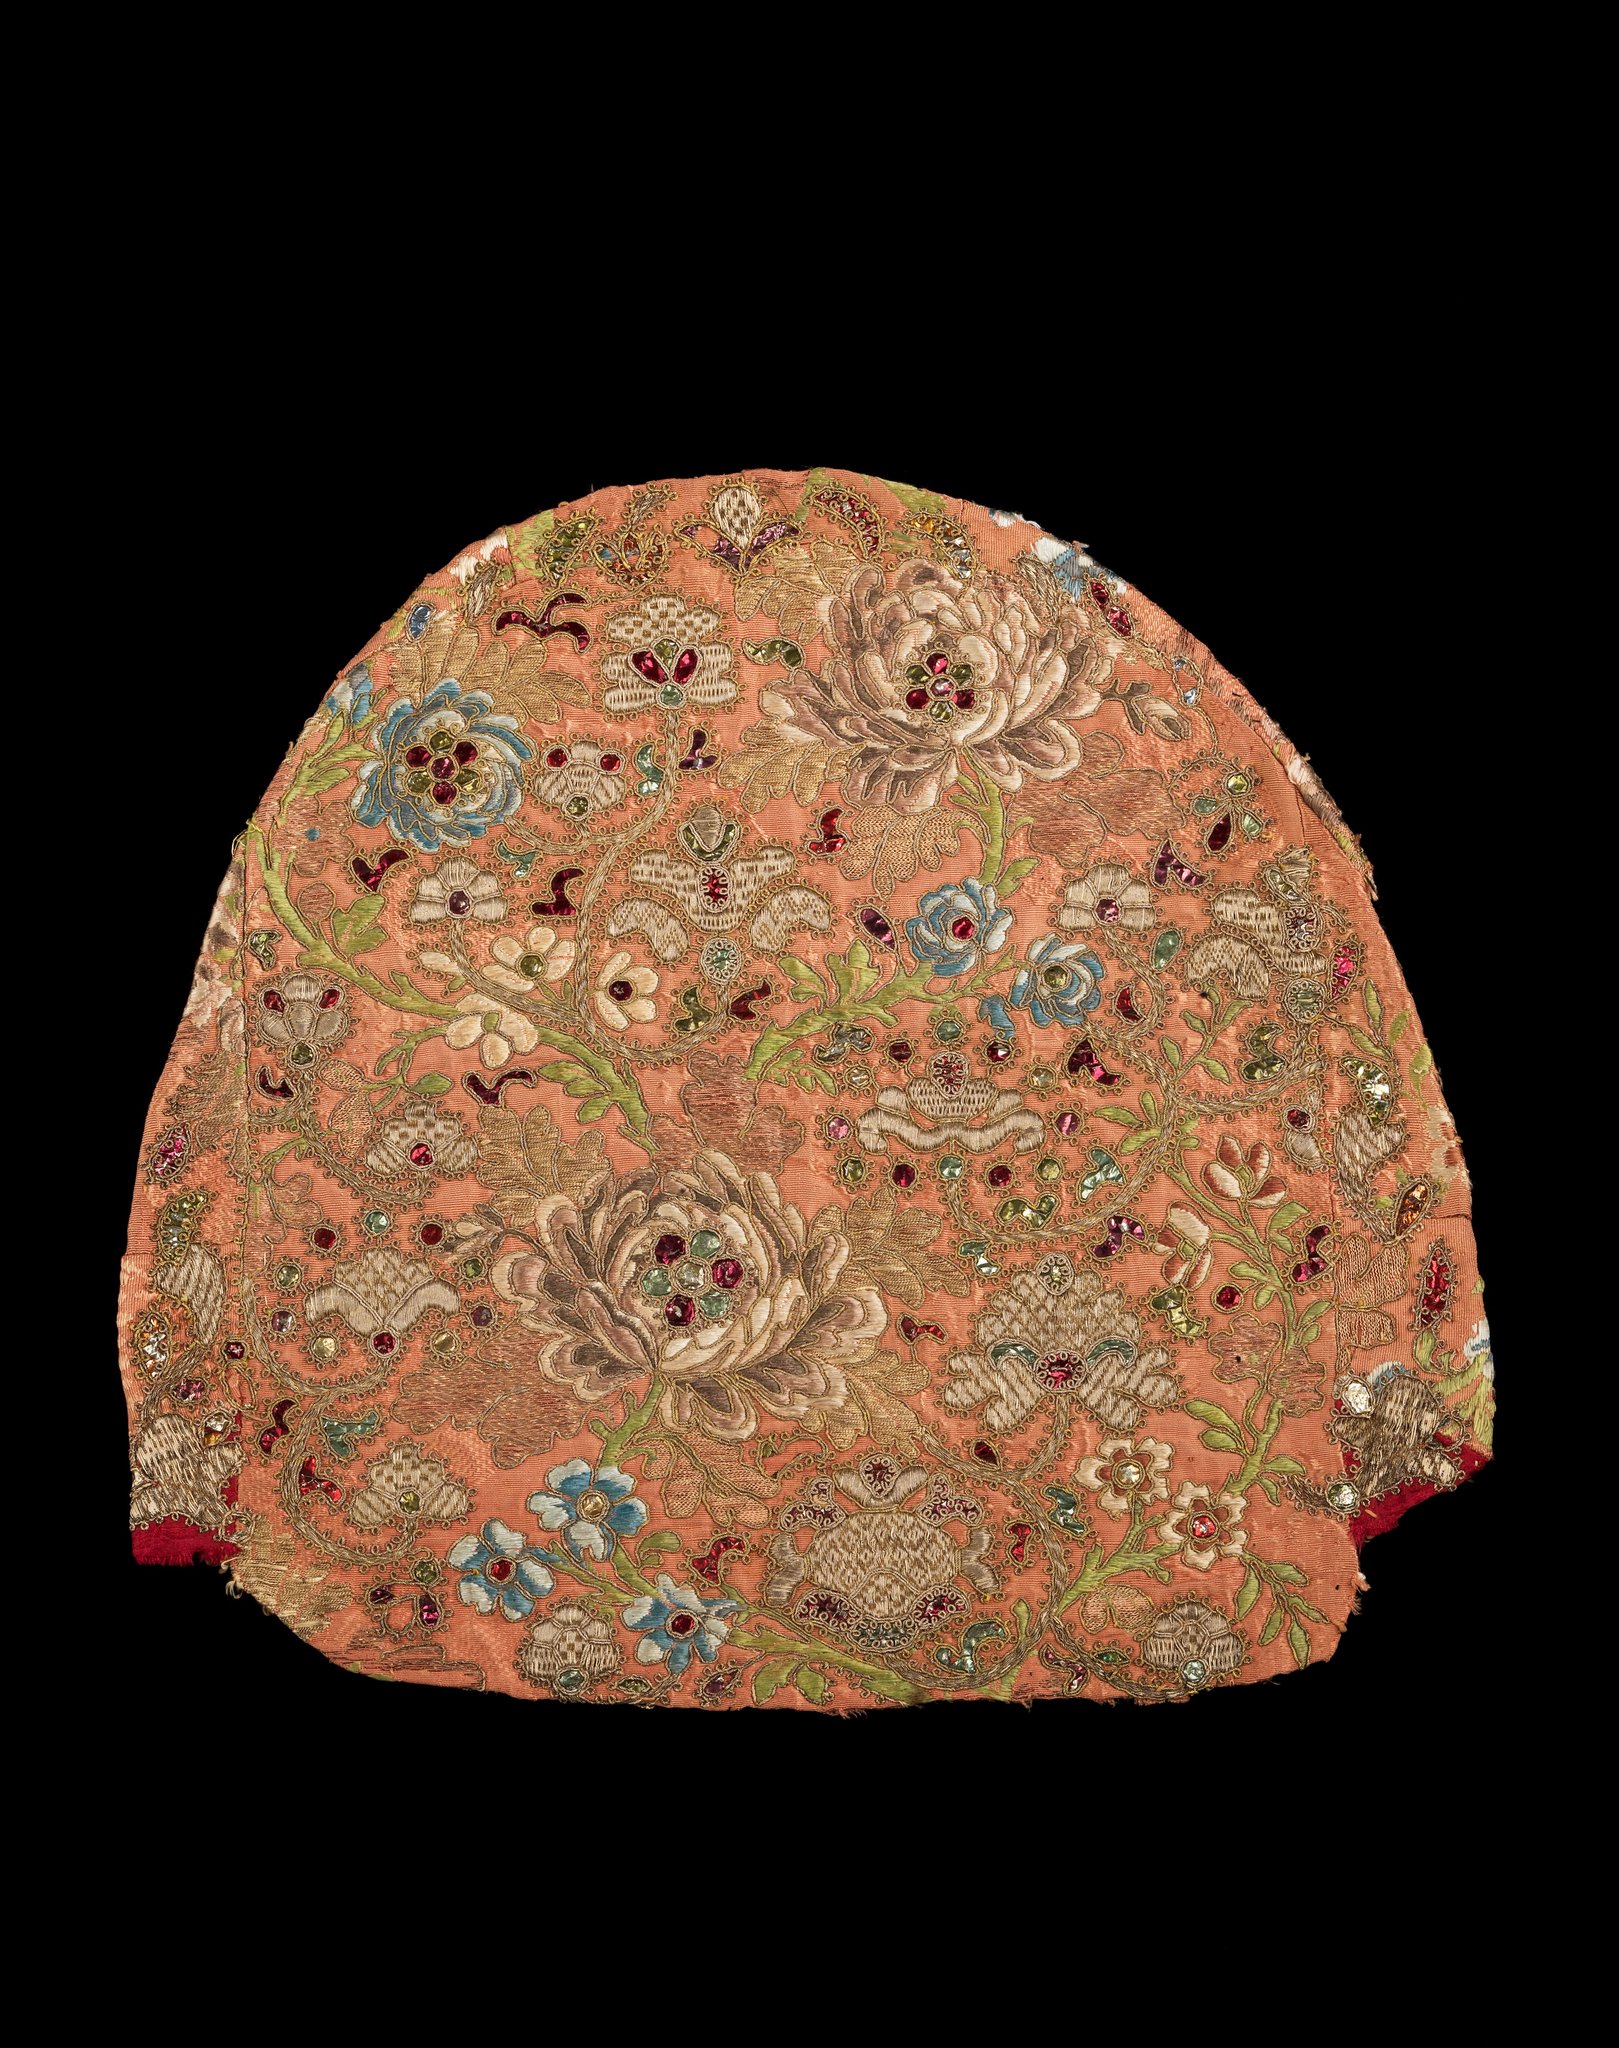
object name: headdress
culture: russian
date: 1776-1800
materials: linen, metal, silk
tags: flowers